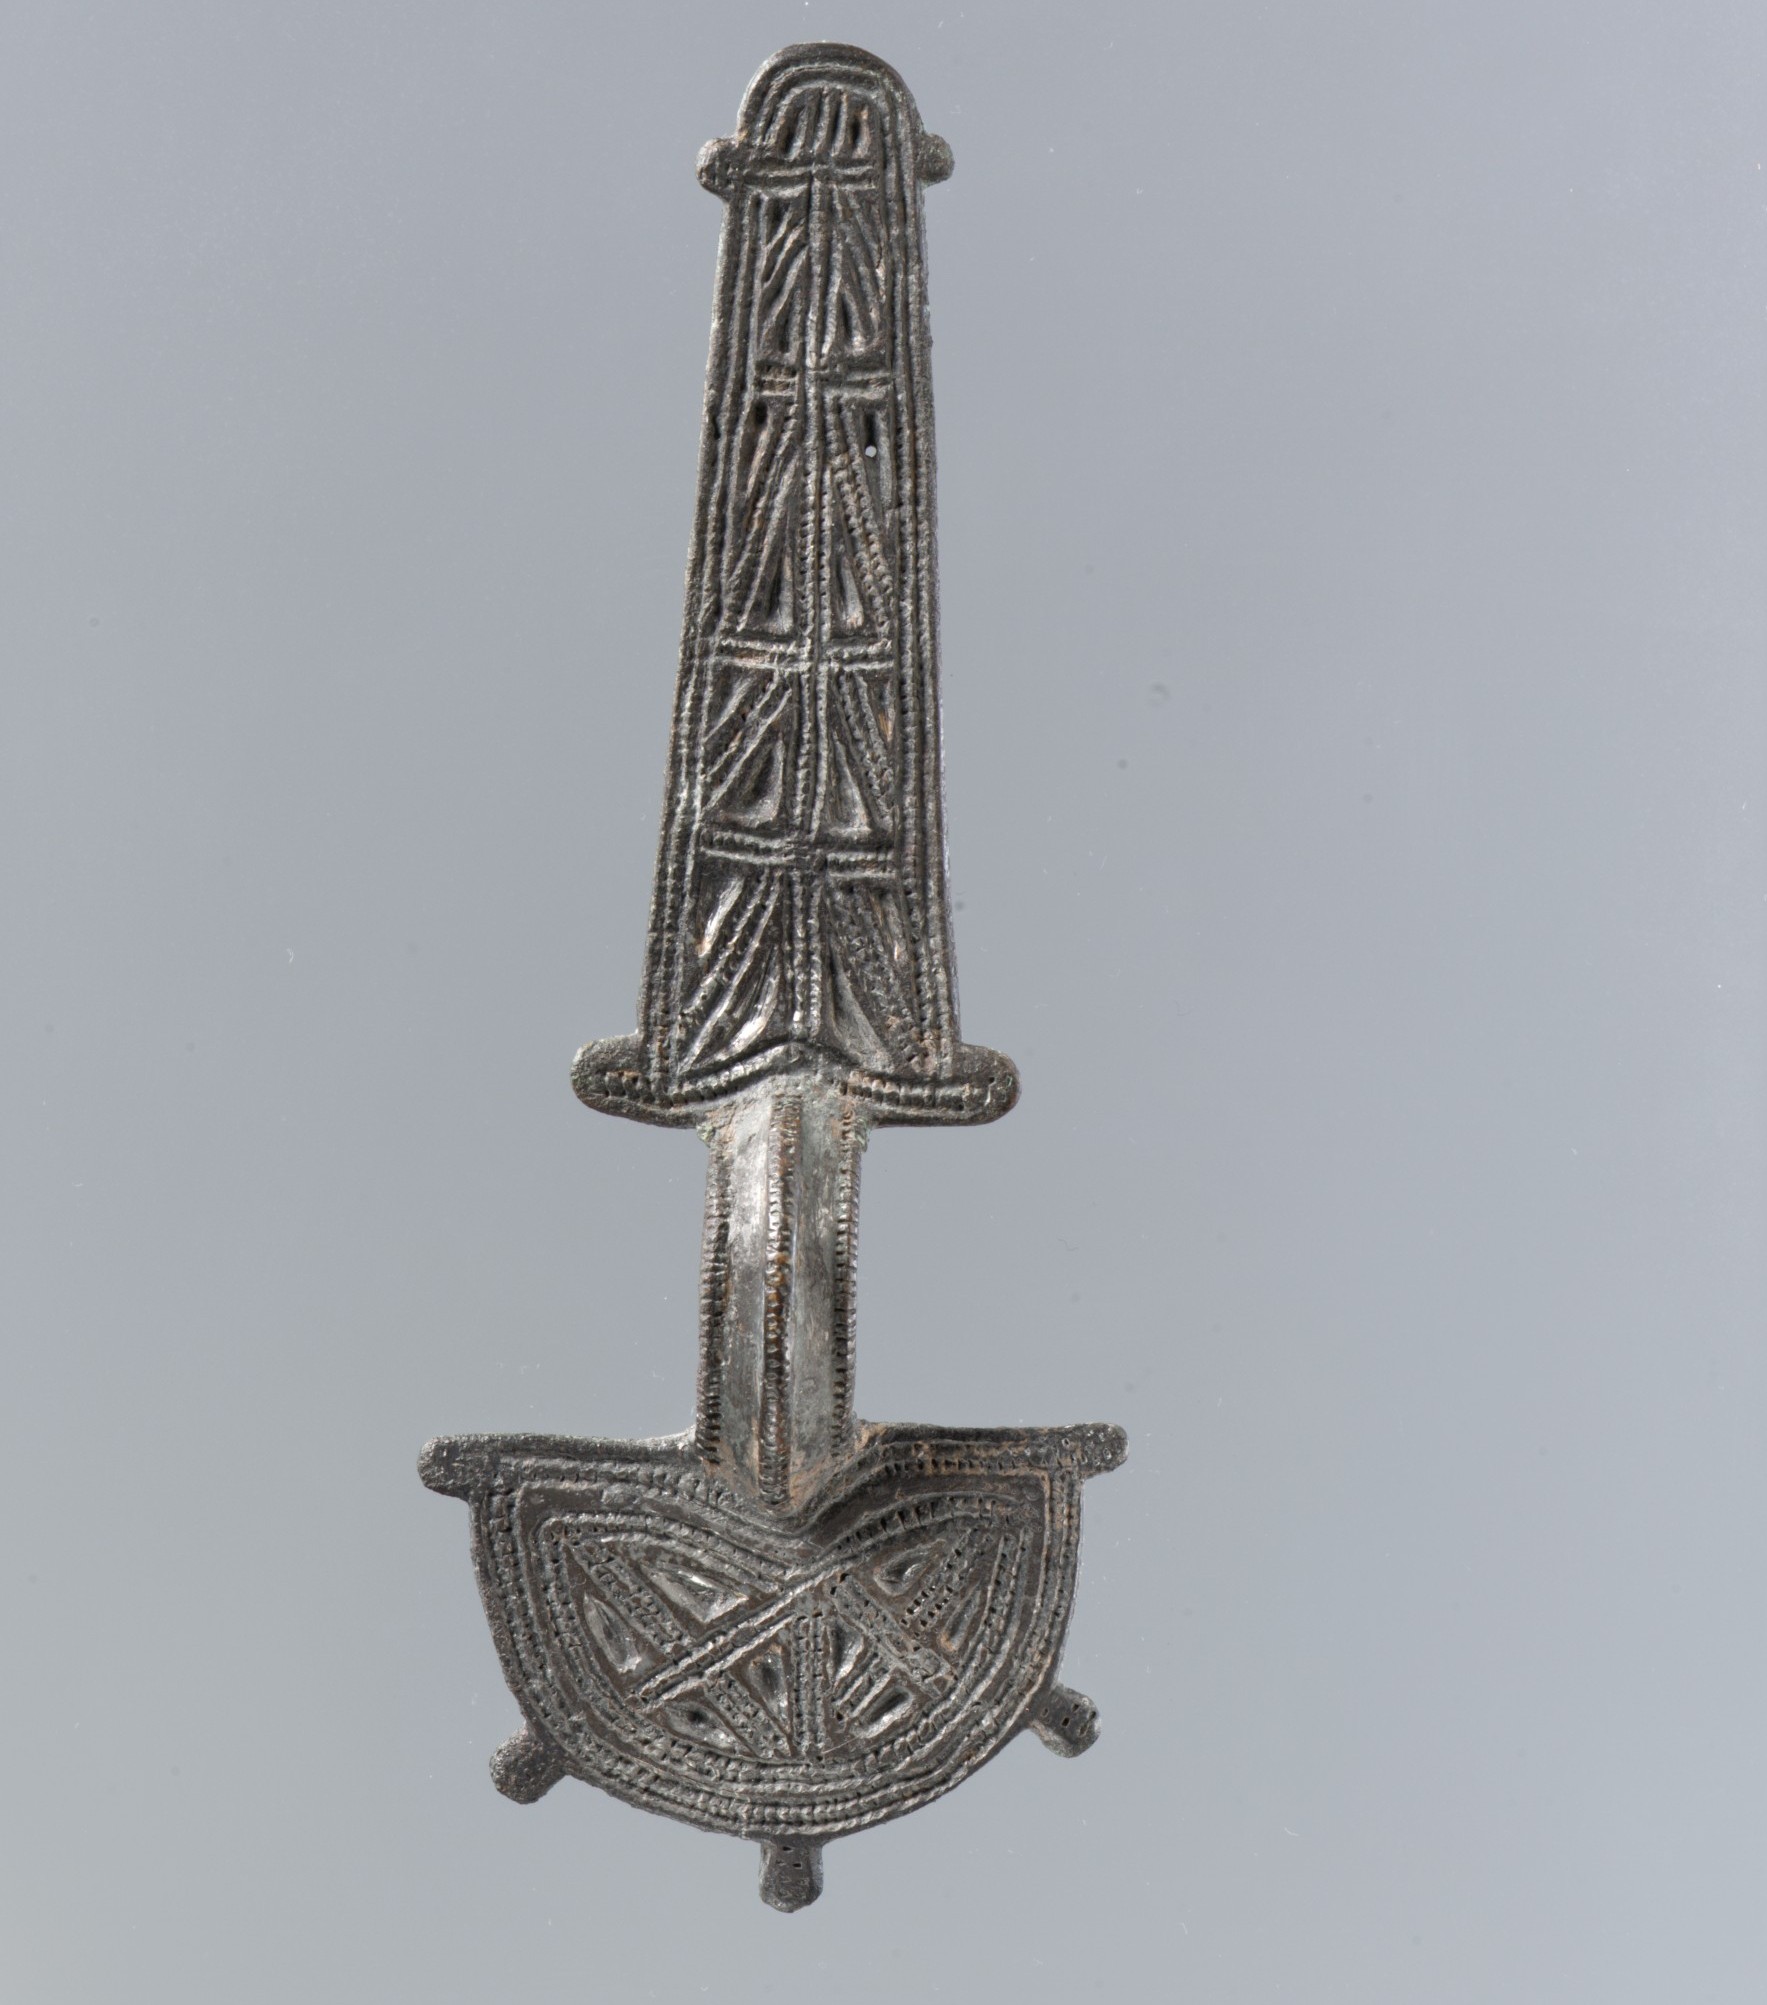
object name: brooch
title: Bow Brooch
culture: visigothic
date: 501-550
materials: copper alloy, iron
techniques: casting